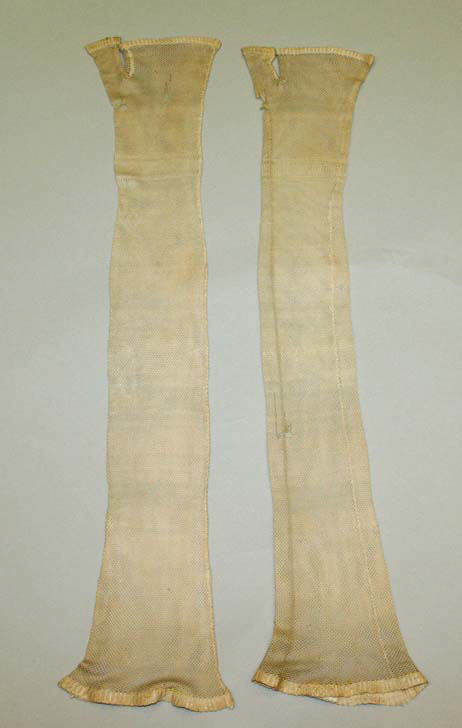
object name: mitt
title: Mitts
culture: italian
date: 1850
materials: silk